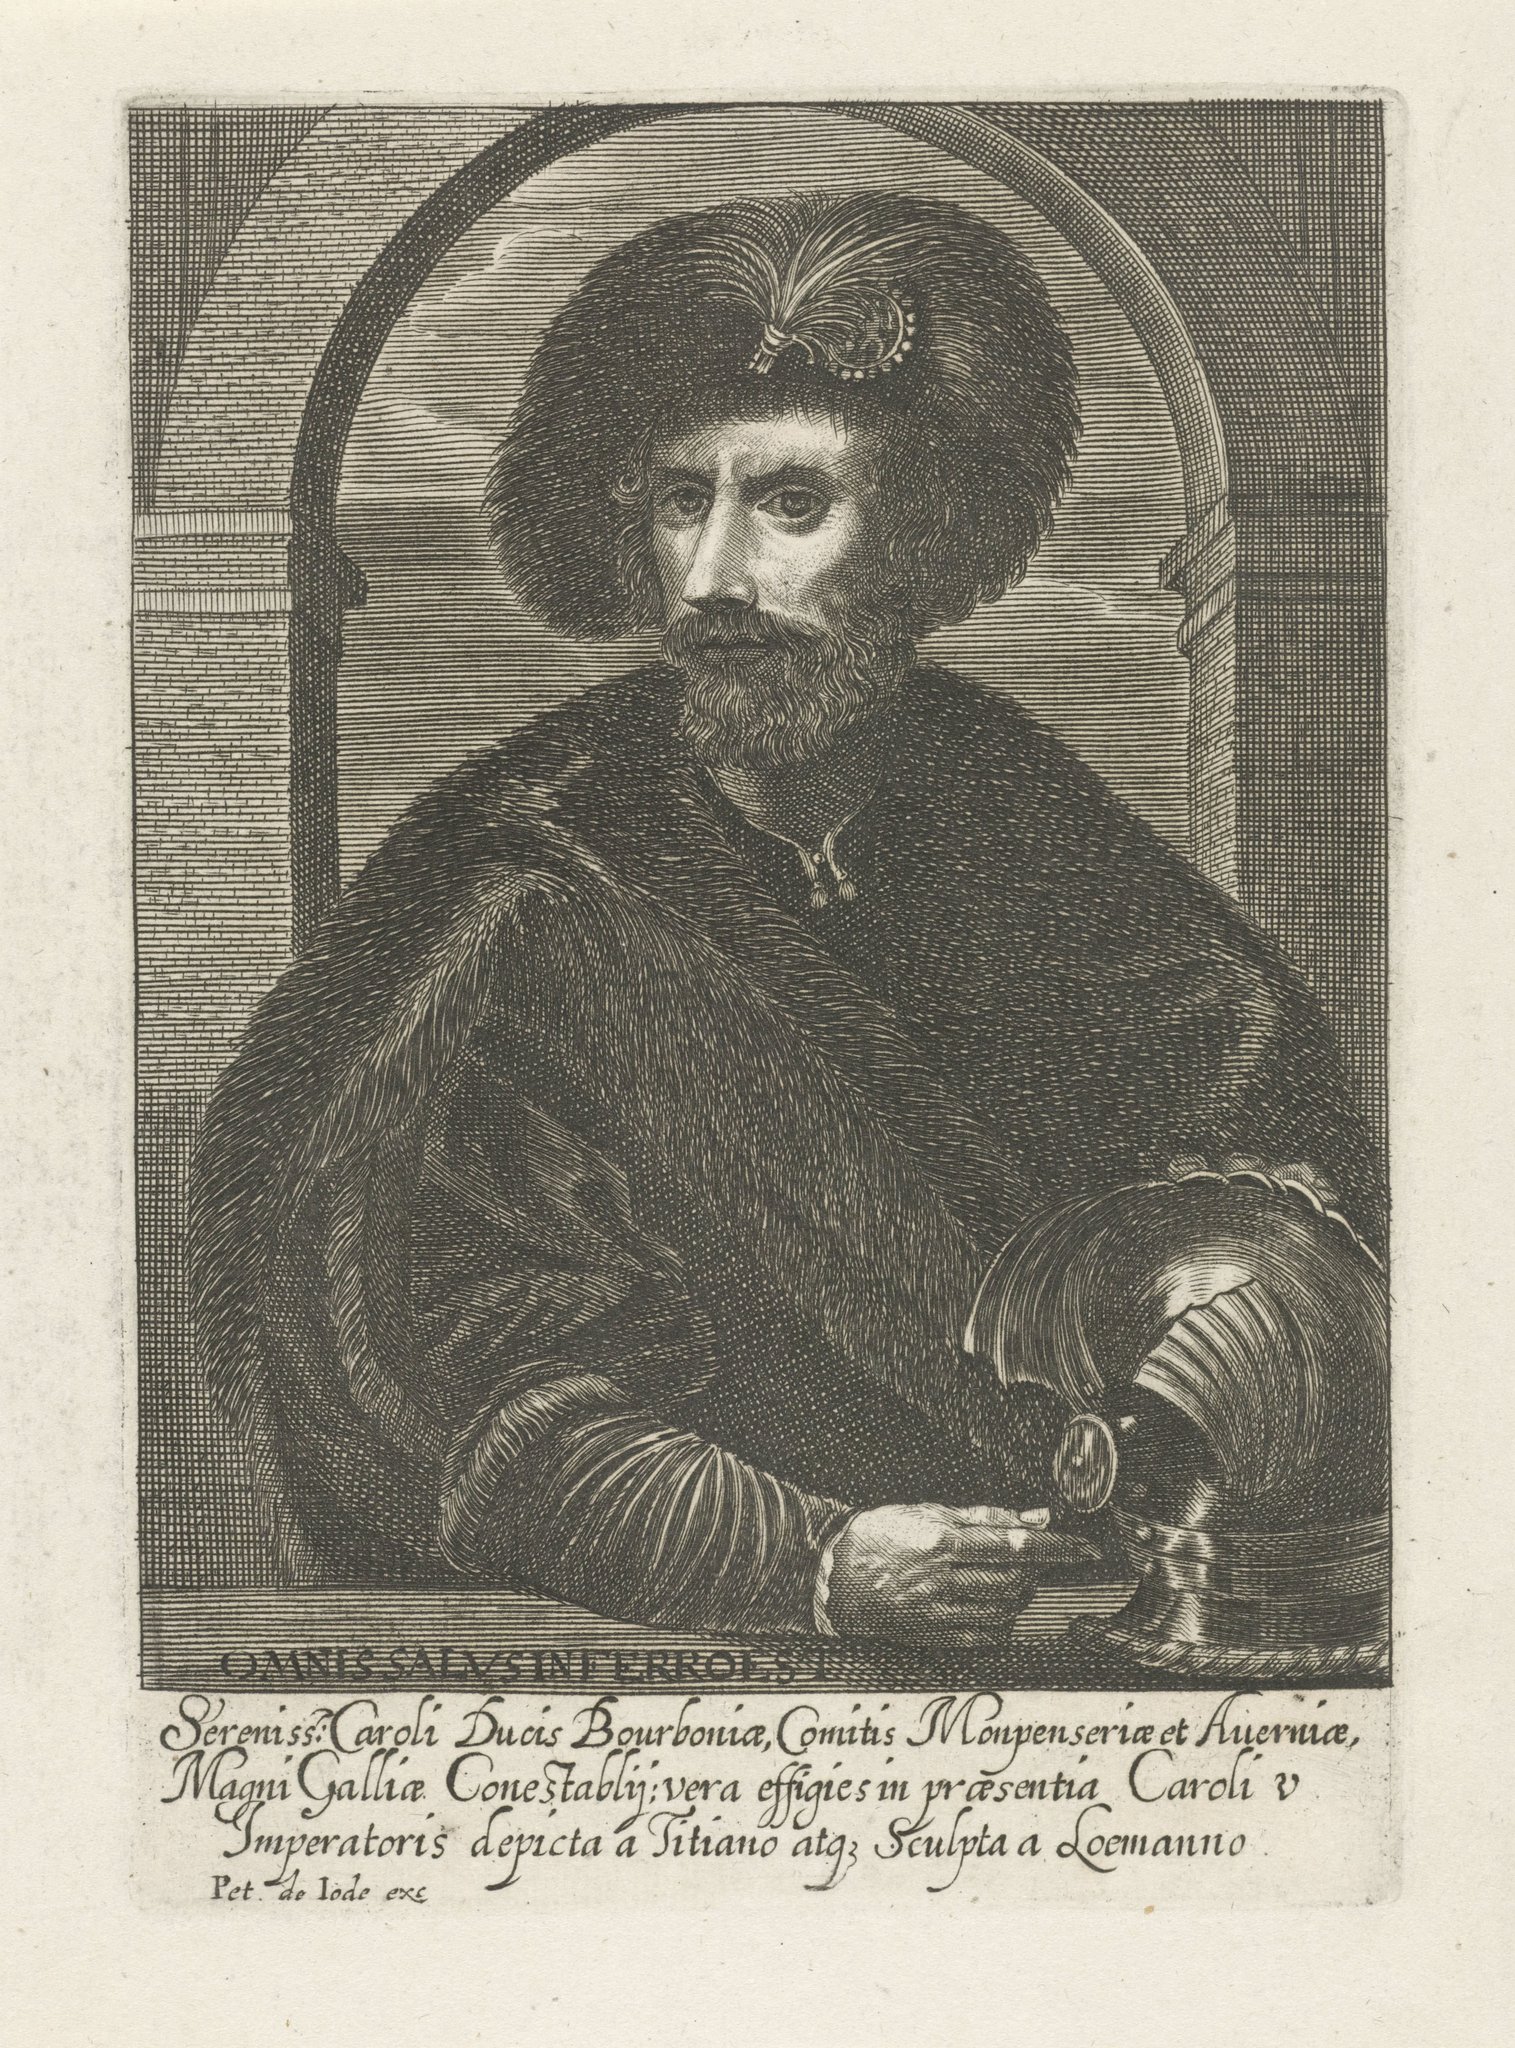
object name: print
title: Portret van Charles de Bourbon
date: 1632-1670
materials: paper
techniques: engraving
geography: antwerp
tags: charles de bourbon (graaf van soissons)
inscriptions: collector's mark: Lugt 2228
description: Portret van Charles de Bourbon, graaf van Soisson.